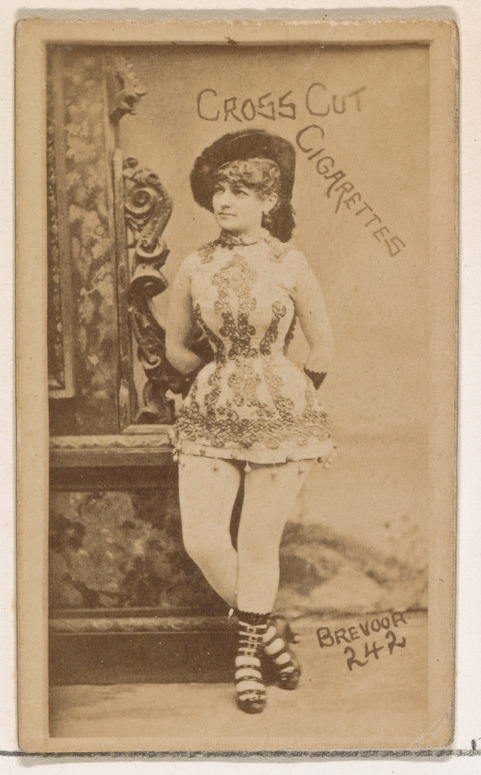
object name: print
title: Card Number 1242, Brevoor, from the Actors and Actresses series (N145-1) issued by Duke Sons & Co. to promote Cross Cut Cigarettes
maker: w. duke, sons & co.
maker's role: publisher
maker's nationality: american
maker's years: 1870-1920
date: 1880-1889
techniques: albumen silver print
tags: portraits,women,actresses